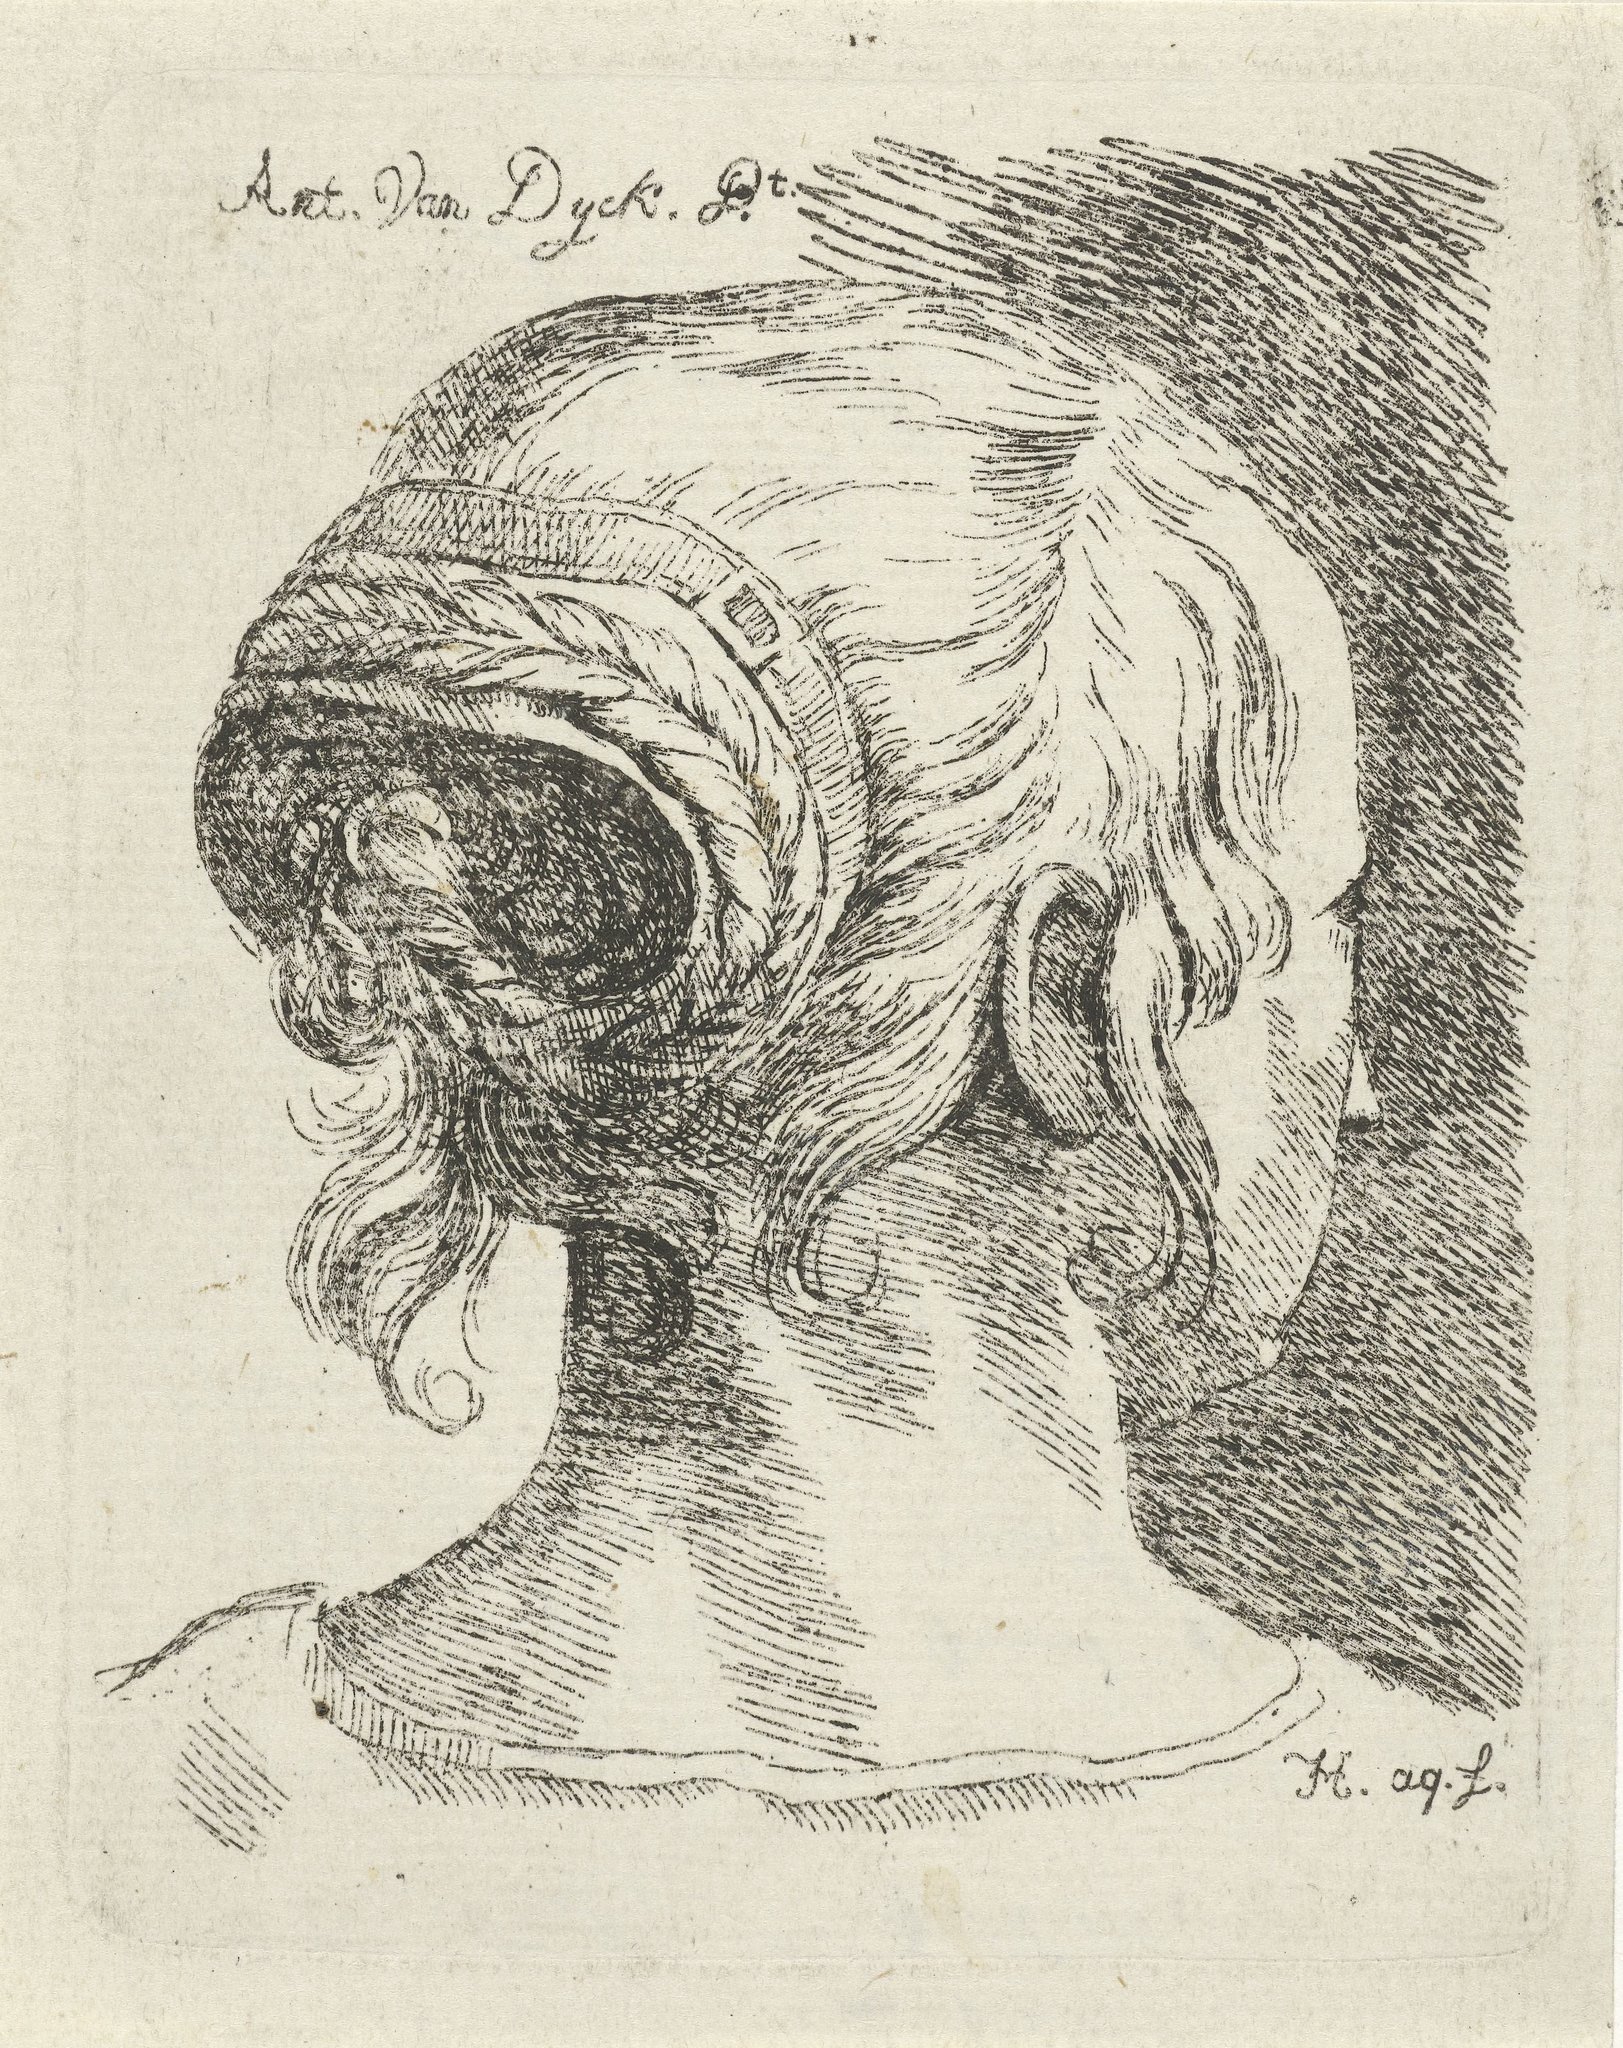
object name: print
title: Hoofd van een vrouw van achteren gezien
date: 1758-1787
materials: paper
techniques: etching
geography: southern netherlands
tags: hair - aa - female human figure (+ back view)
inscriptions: inscription: ‘Lijst Franse woorden en hun Nederlandse betekenis’, collector's mark: Lugt 2228